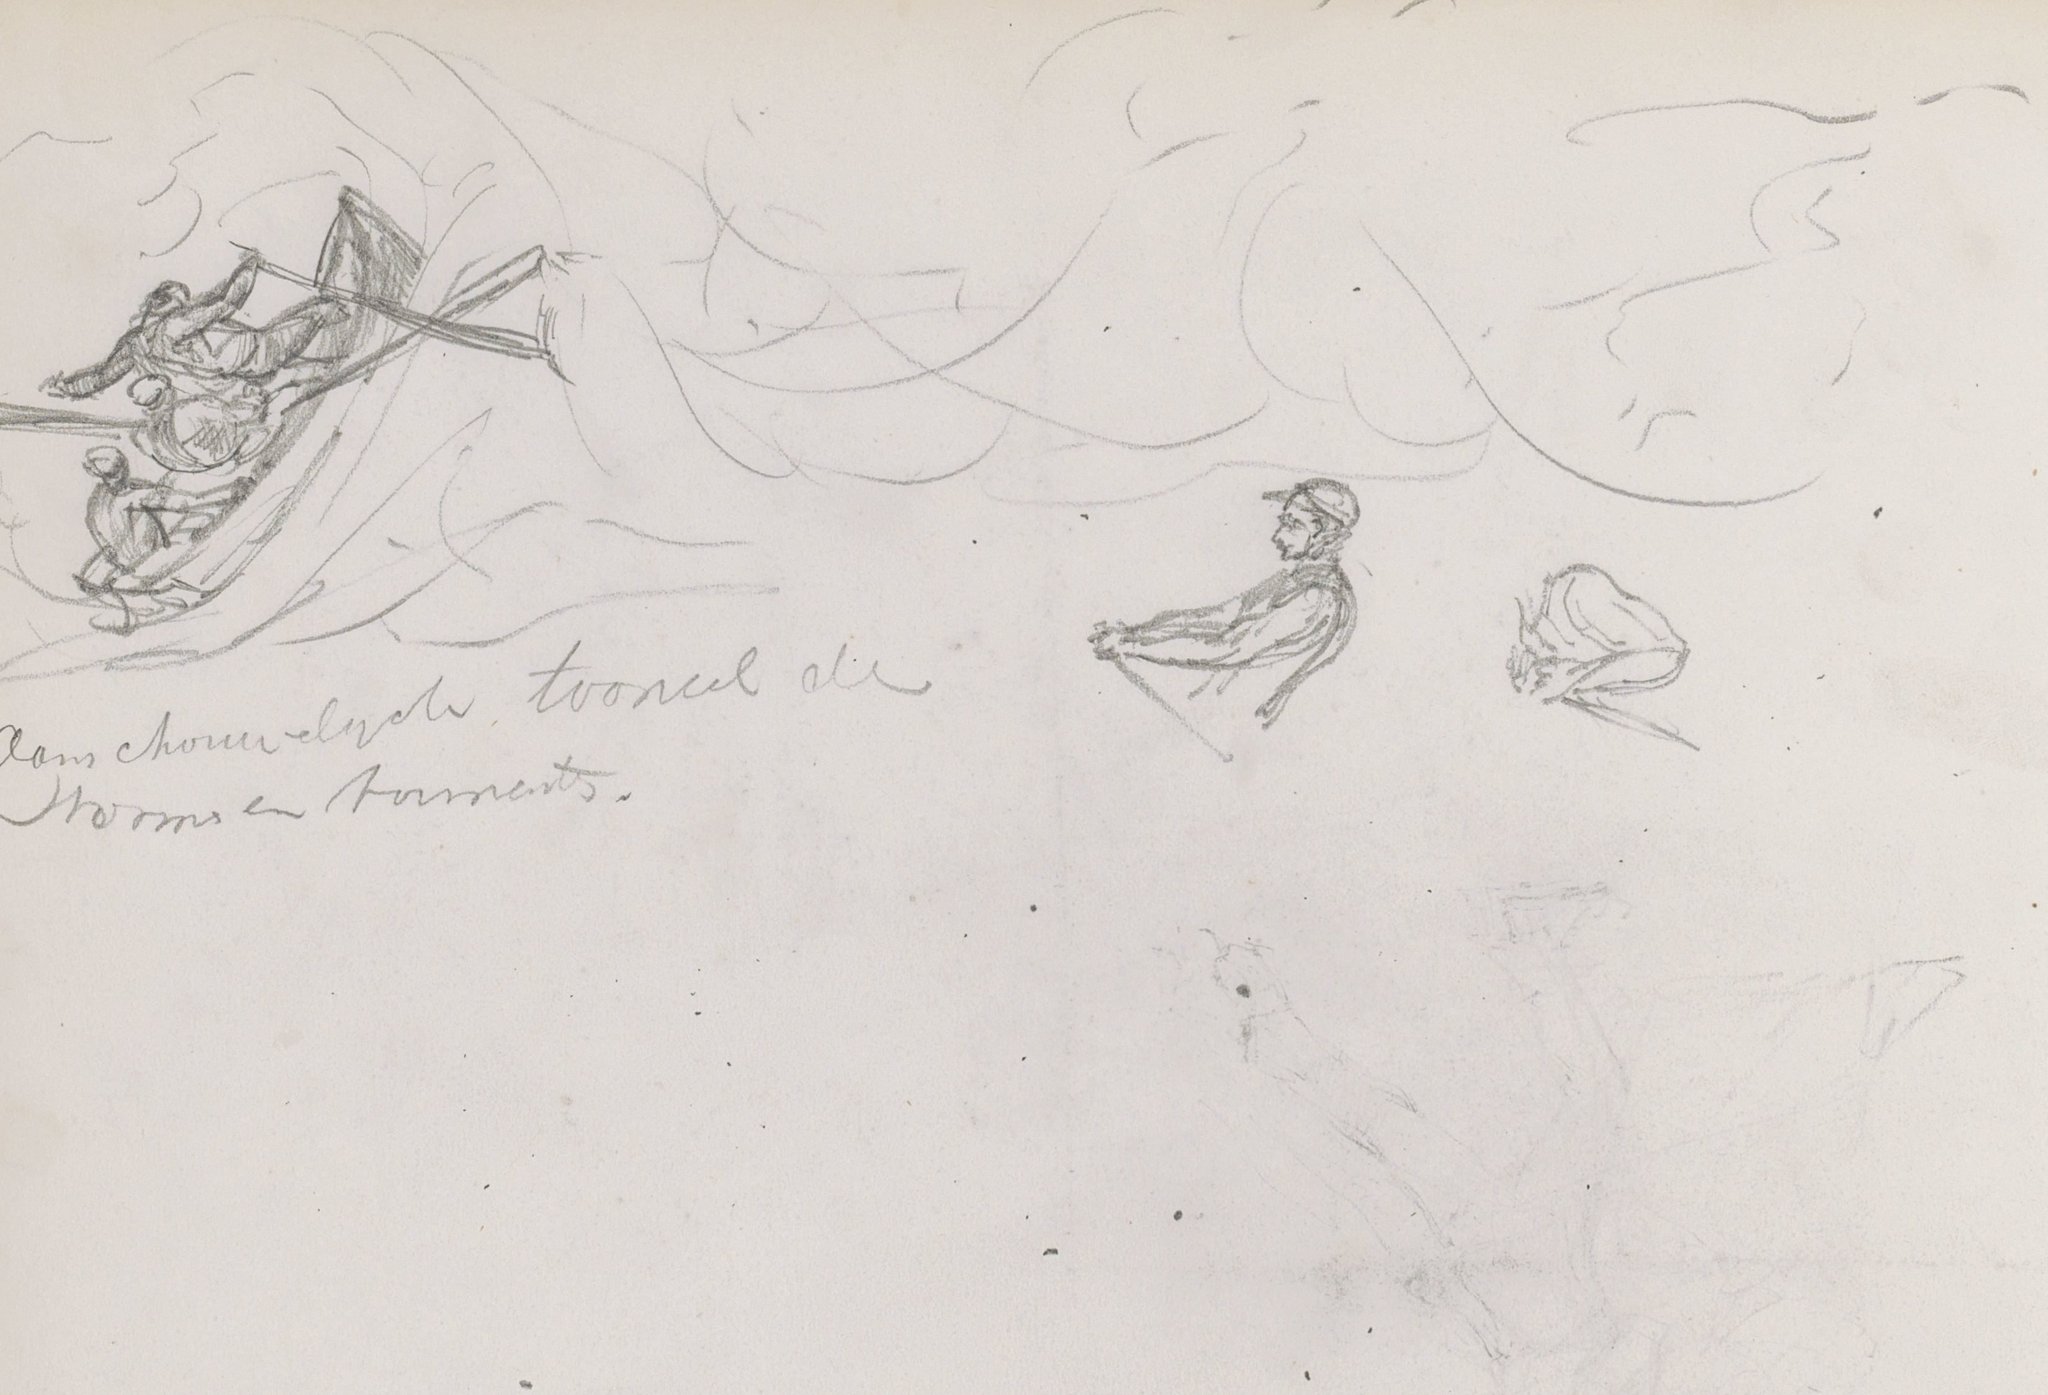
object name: sketchbook leaf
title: Soldaten in een boot op zee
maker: george hendrik breitner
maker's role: draughtsman, painter, print maker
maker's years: 1857-1923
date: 1873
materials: paper, pencil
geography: rotterdam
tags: division of armed forces (+ naval force), ships (in general), sea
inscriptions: annotation: ‘Aanschouwelyck tooneel de/ storms en torments’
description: Blad 34 verso uit een schetsboek met 25 bladen.